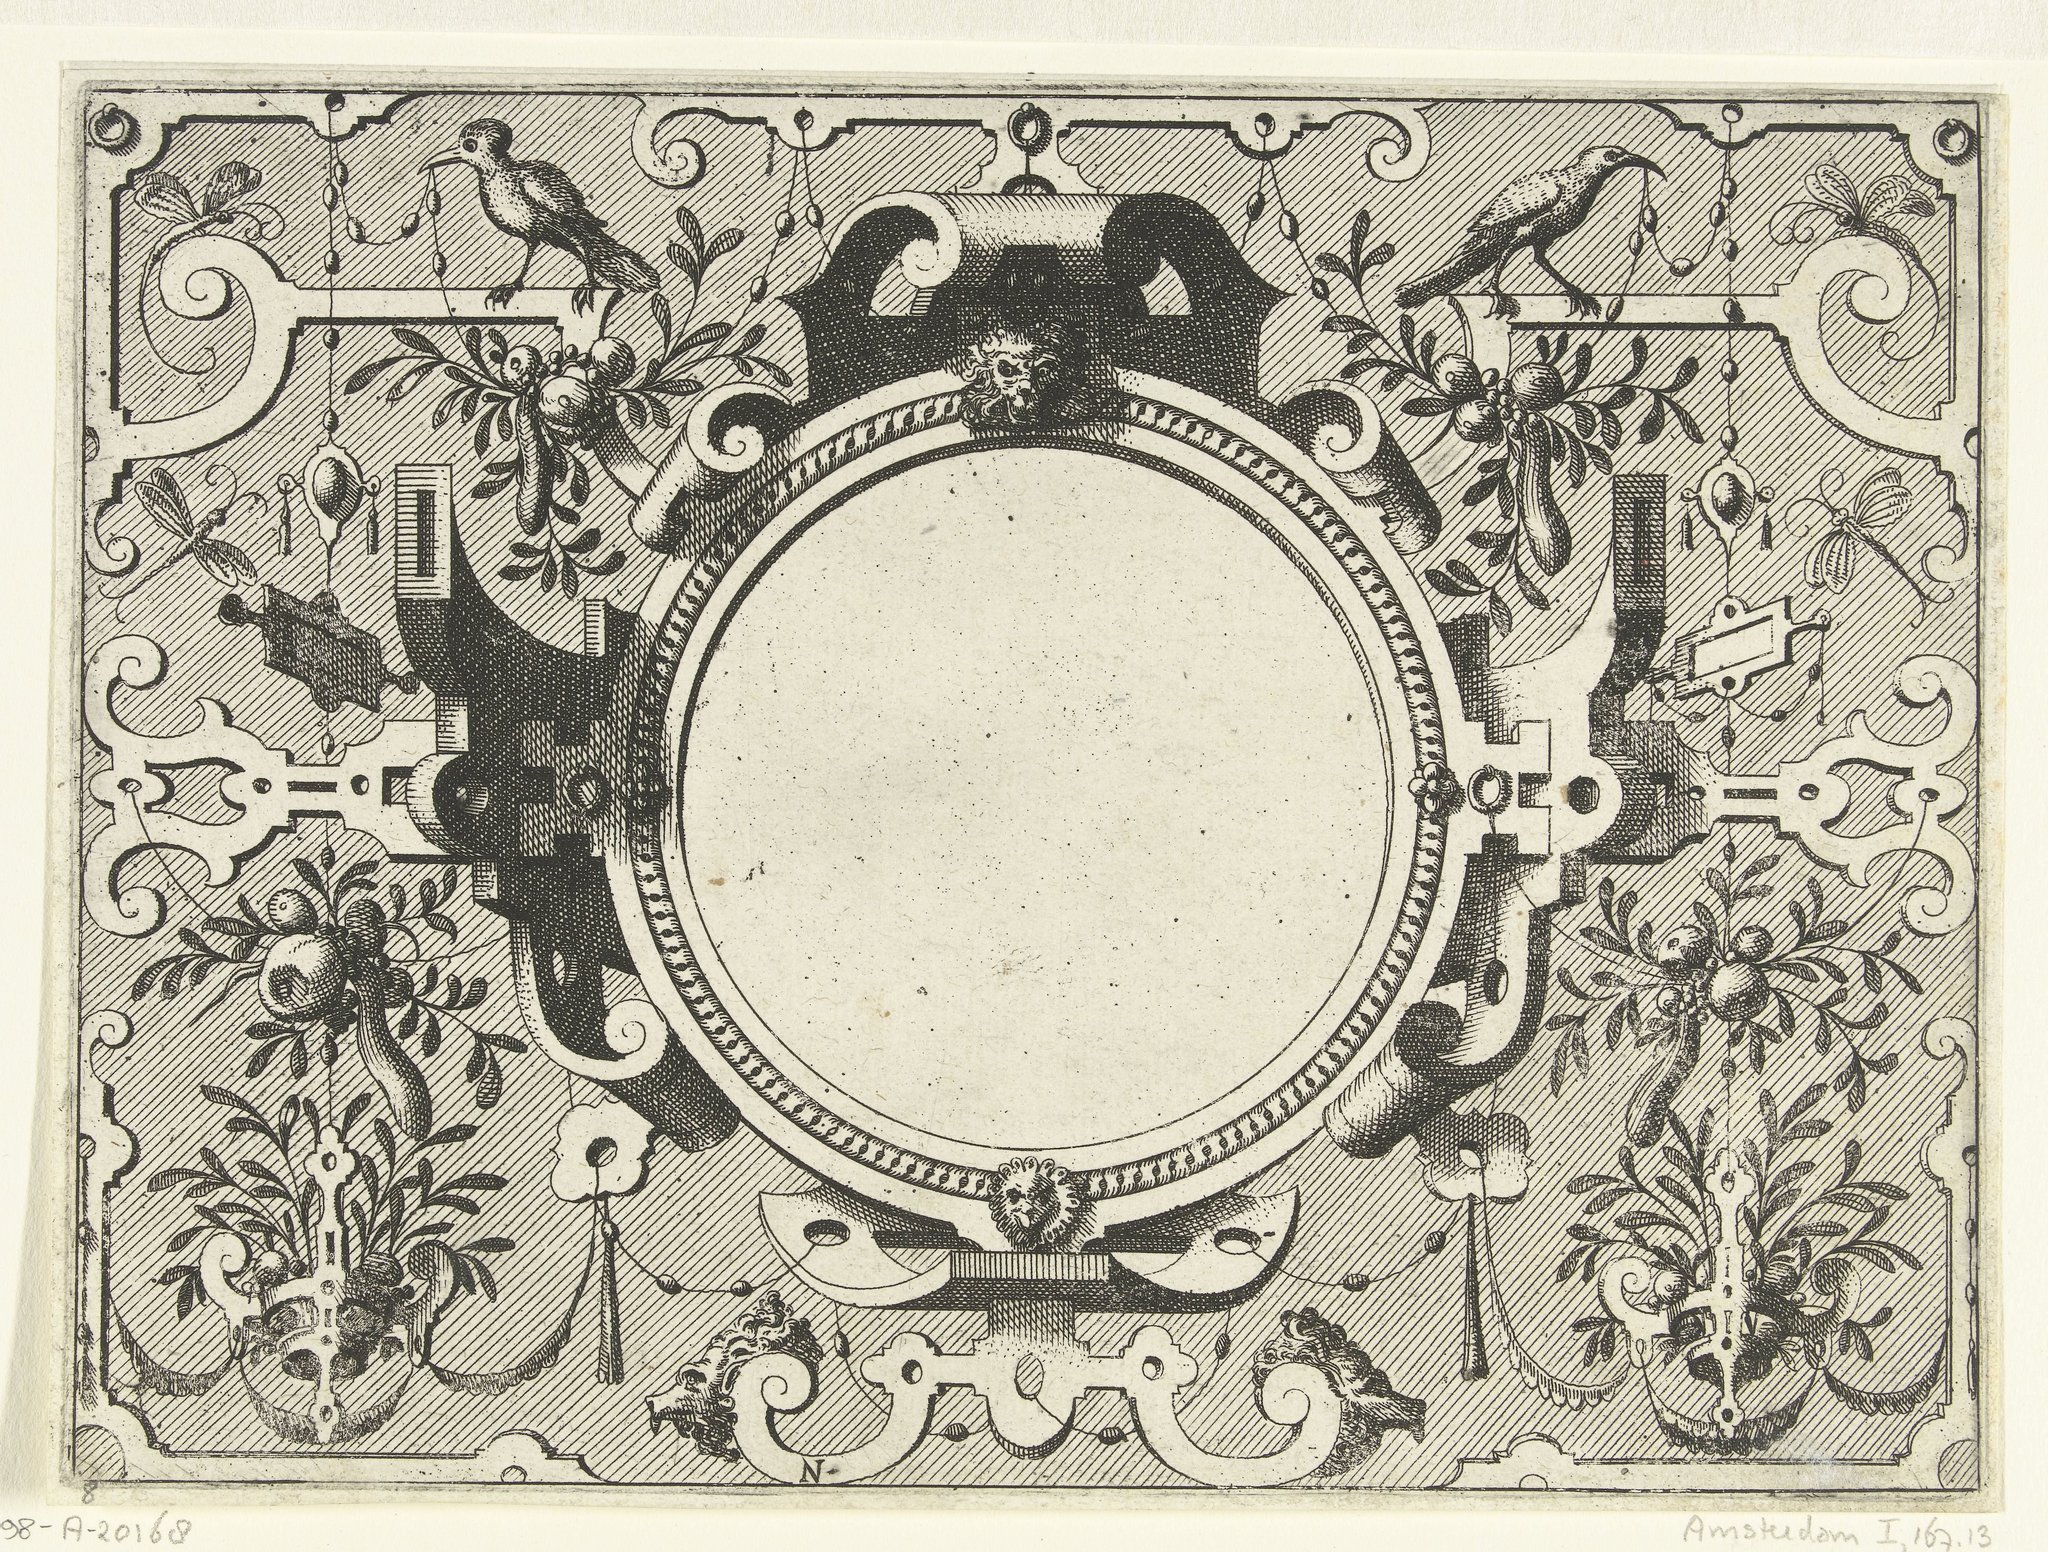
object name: ornament print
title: Cartouches in een omlijsting van rol- en beslagwerk met grotesken, moresken, guirlandes, mascarons en trofeeën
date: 1555-1560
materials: paper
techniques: etching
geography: netherlands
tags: fruits and vegetables ~ ornament, birds, ornament ~ cartouche, ornament ~ festoon, garland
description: Het rolwerk onder de cartouche loopt uit in twee zwijnskoppen. Links- en rechtsboven een vogel. Blad N uit serie van 16 bladen, geletterd A-Q. Gearceerde of gestippelde achtergrond.